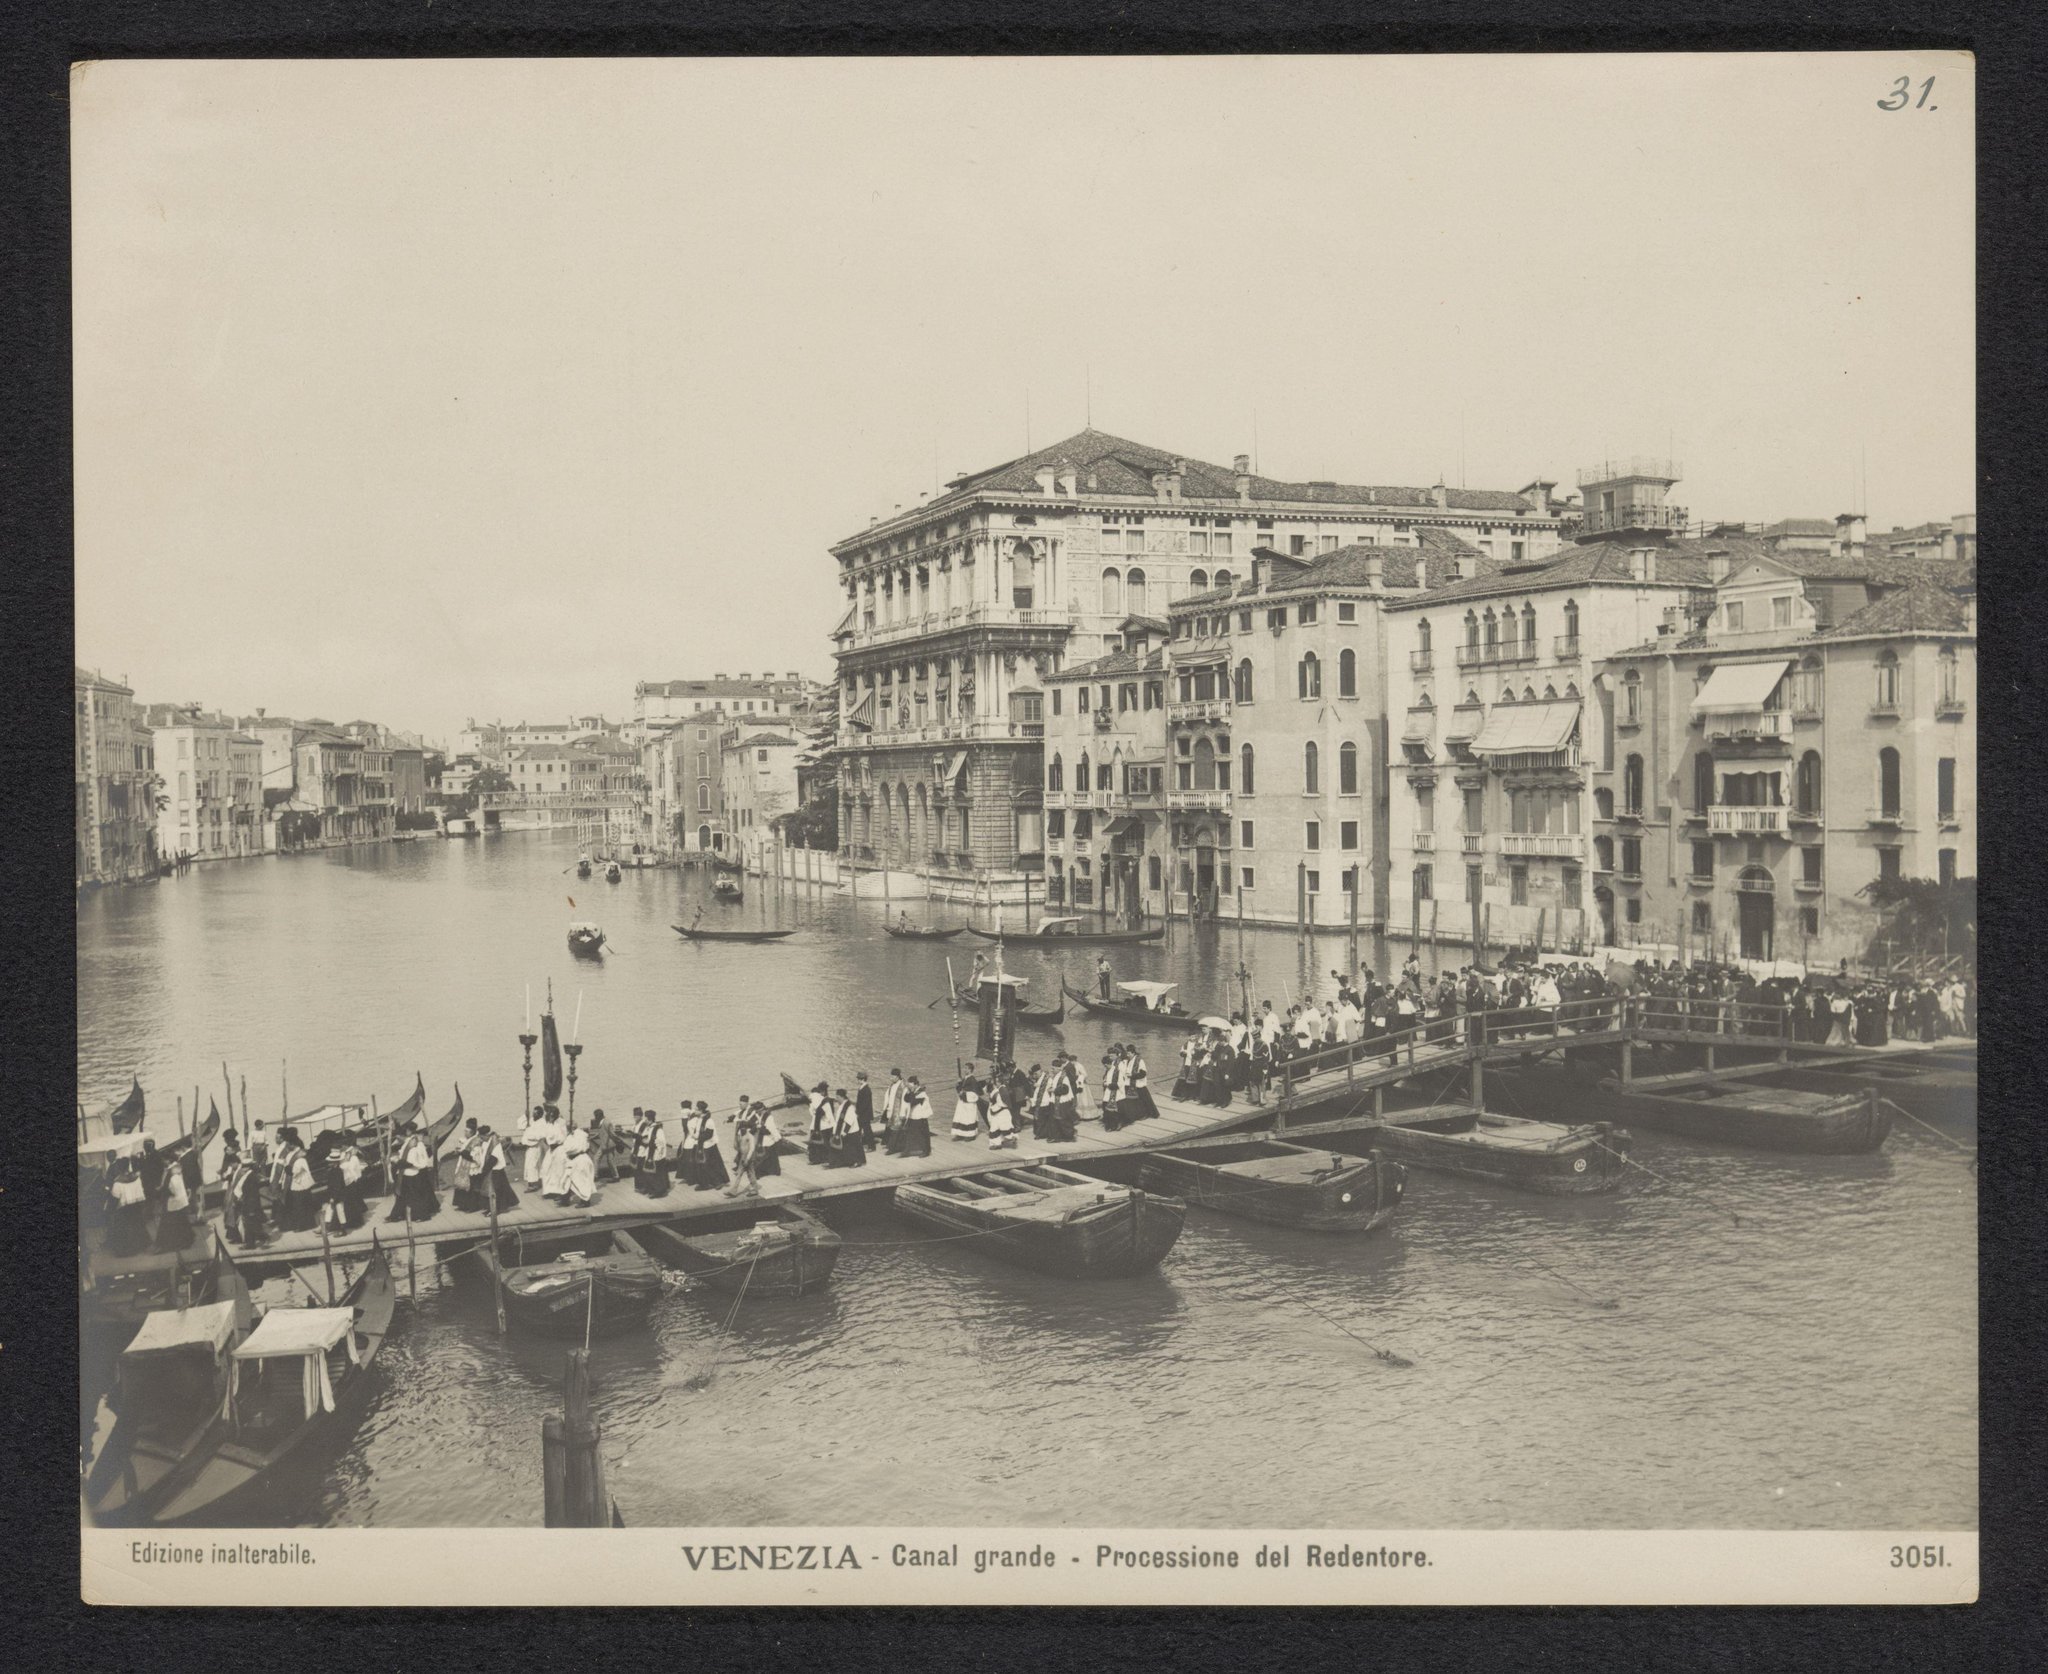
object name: photograph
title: Venezia - Canal Grande - Processione del Redentore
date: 1900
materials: cardboard, photographic support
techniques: gelatin silver print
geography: venice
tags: canal, procession ~ christian religion, pontoon bridge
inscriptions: number: ‘3051.’, number: ‘31.’